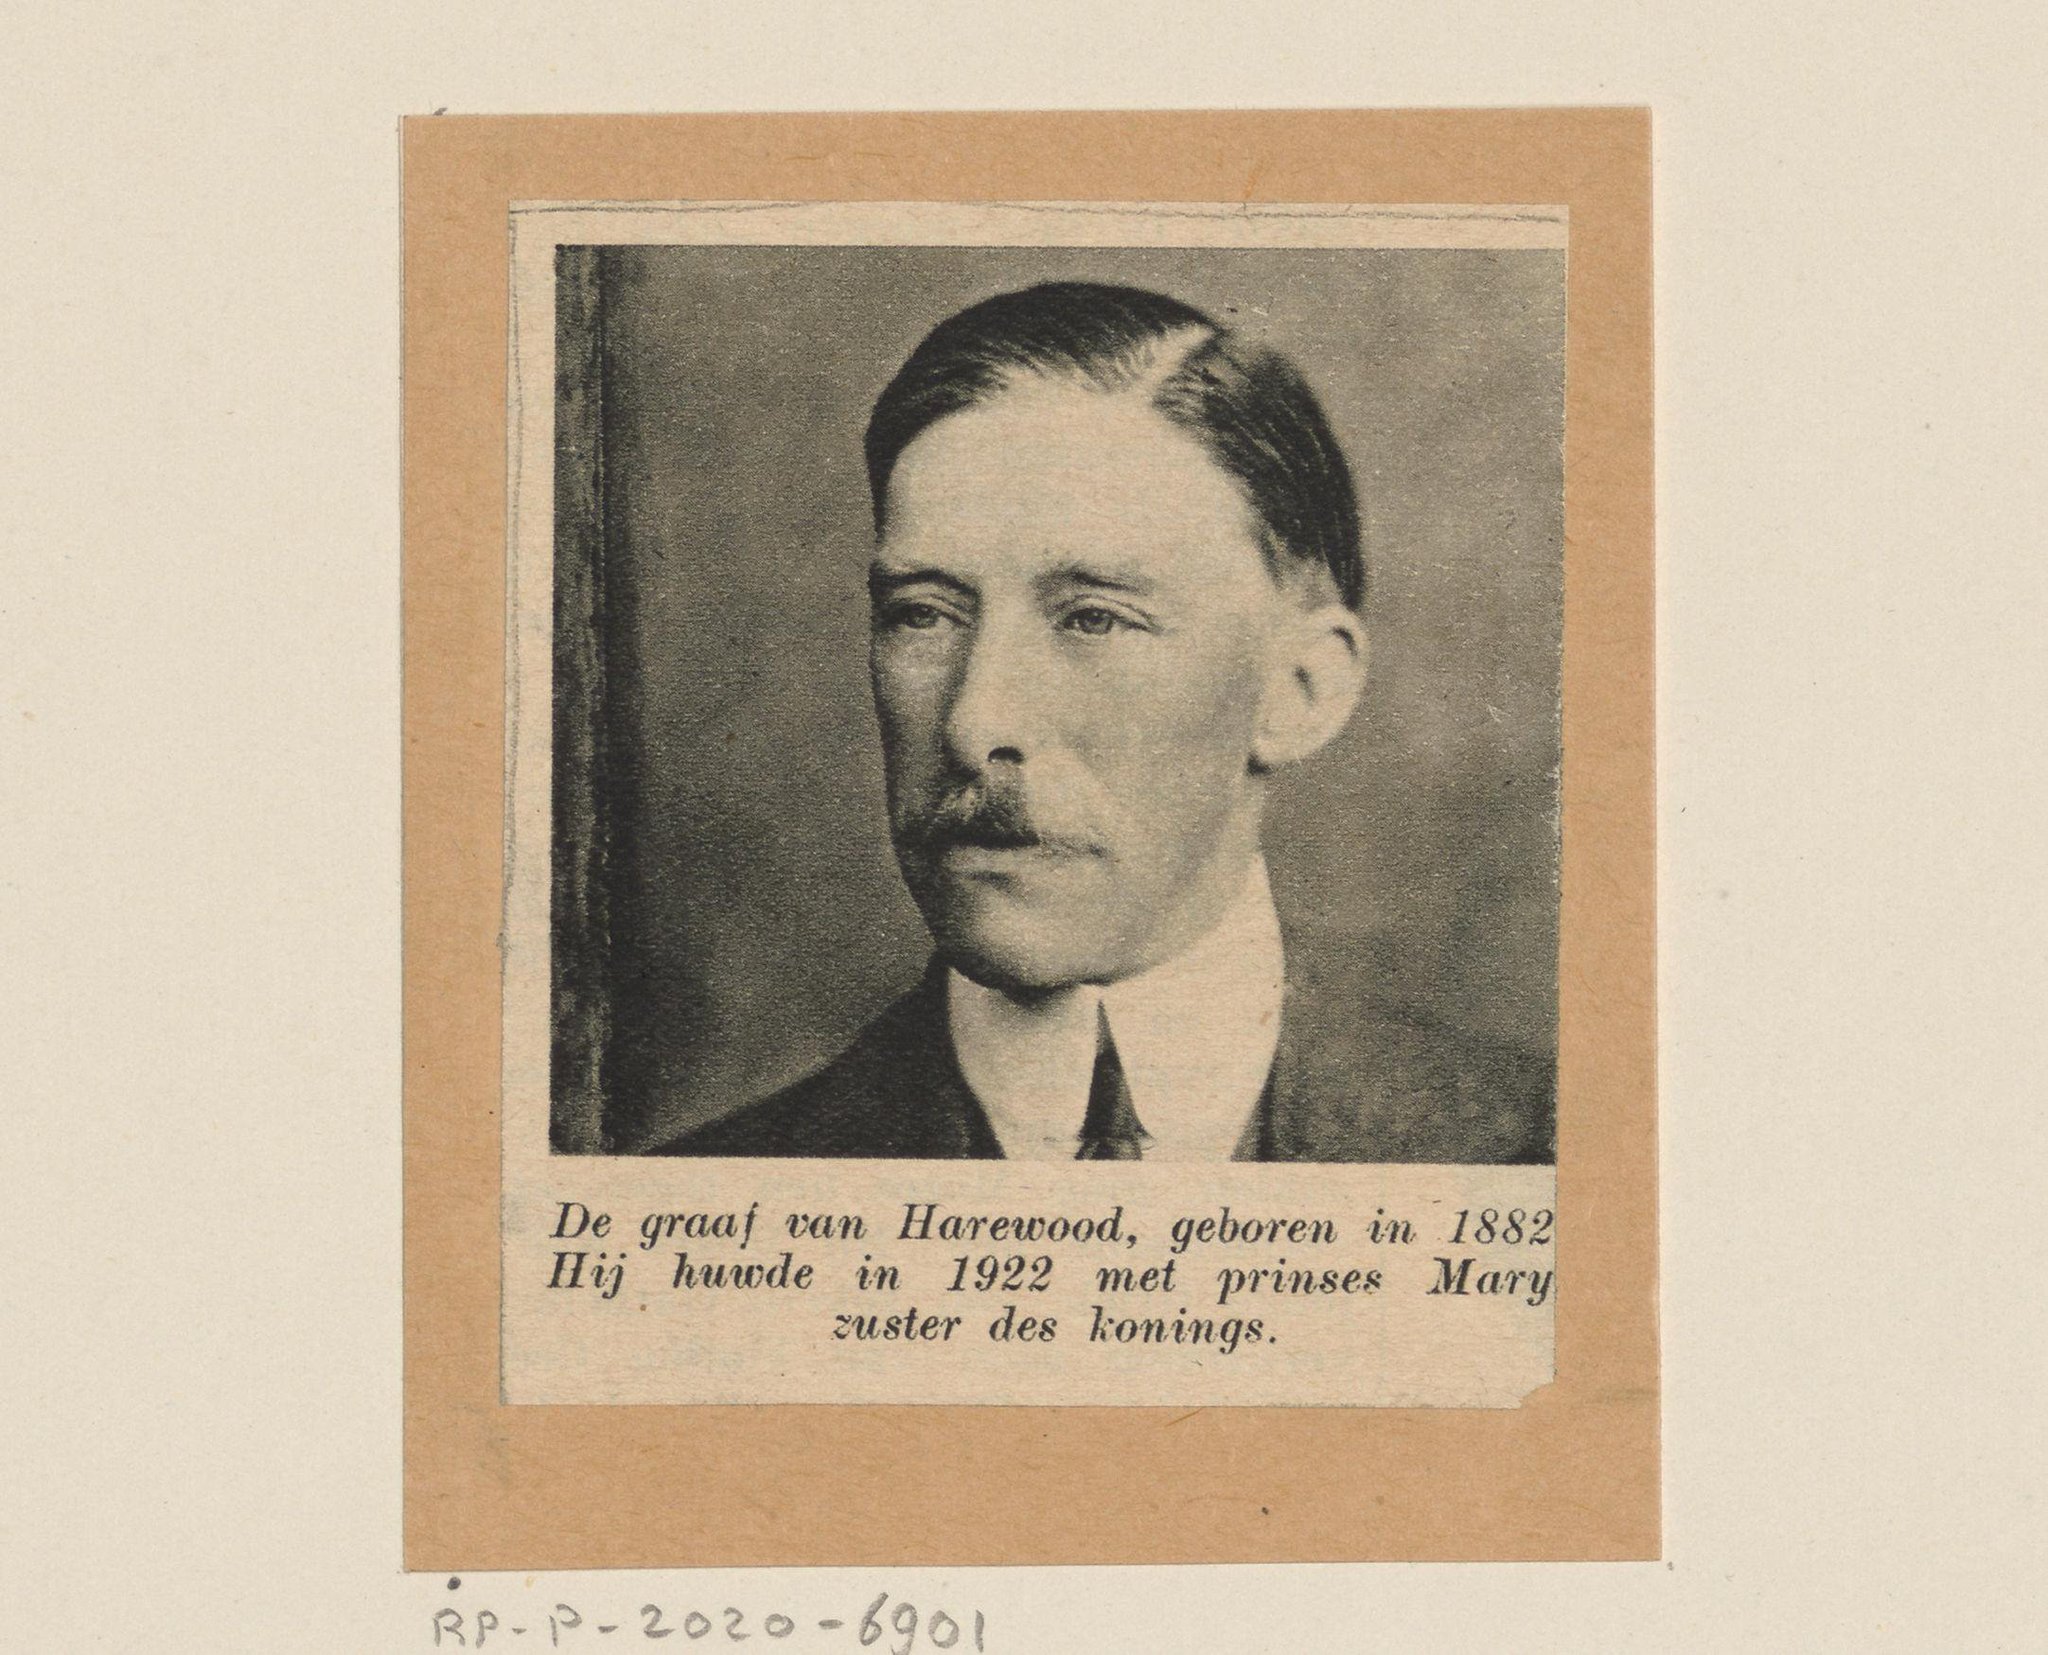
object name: print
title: Portret van Henry Lascelles, graaf van Harewood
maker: Anonymous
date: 1922-1949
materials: paper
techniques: rotogravure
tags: earl, historical persons